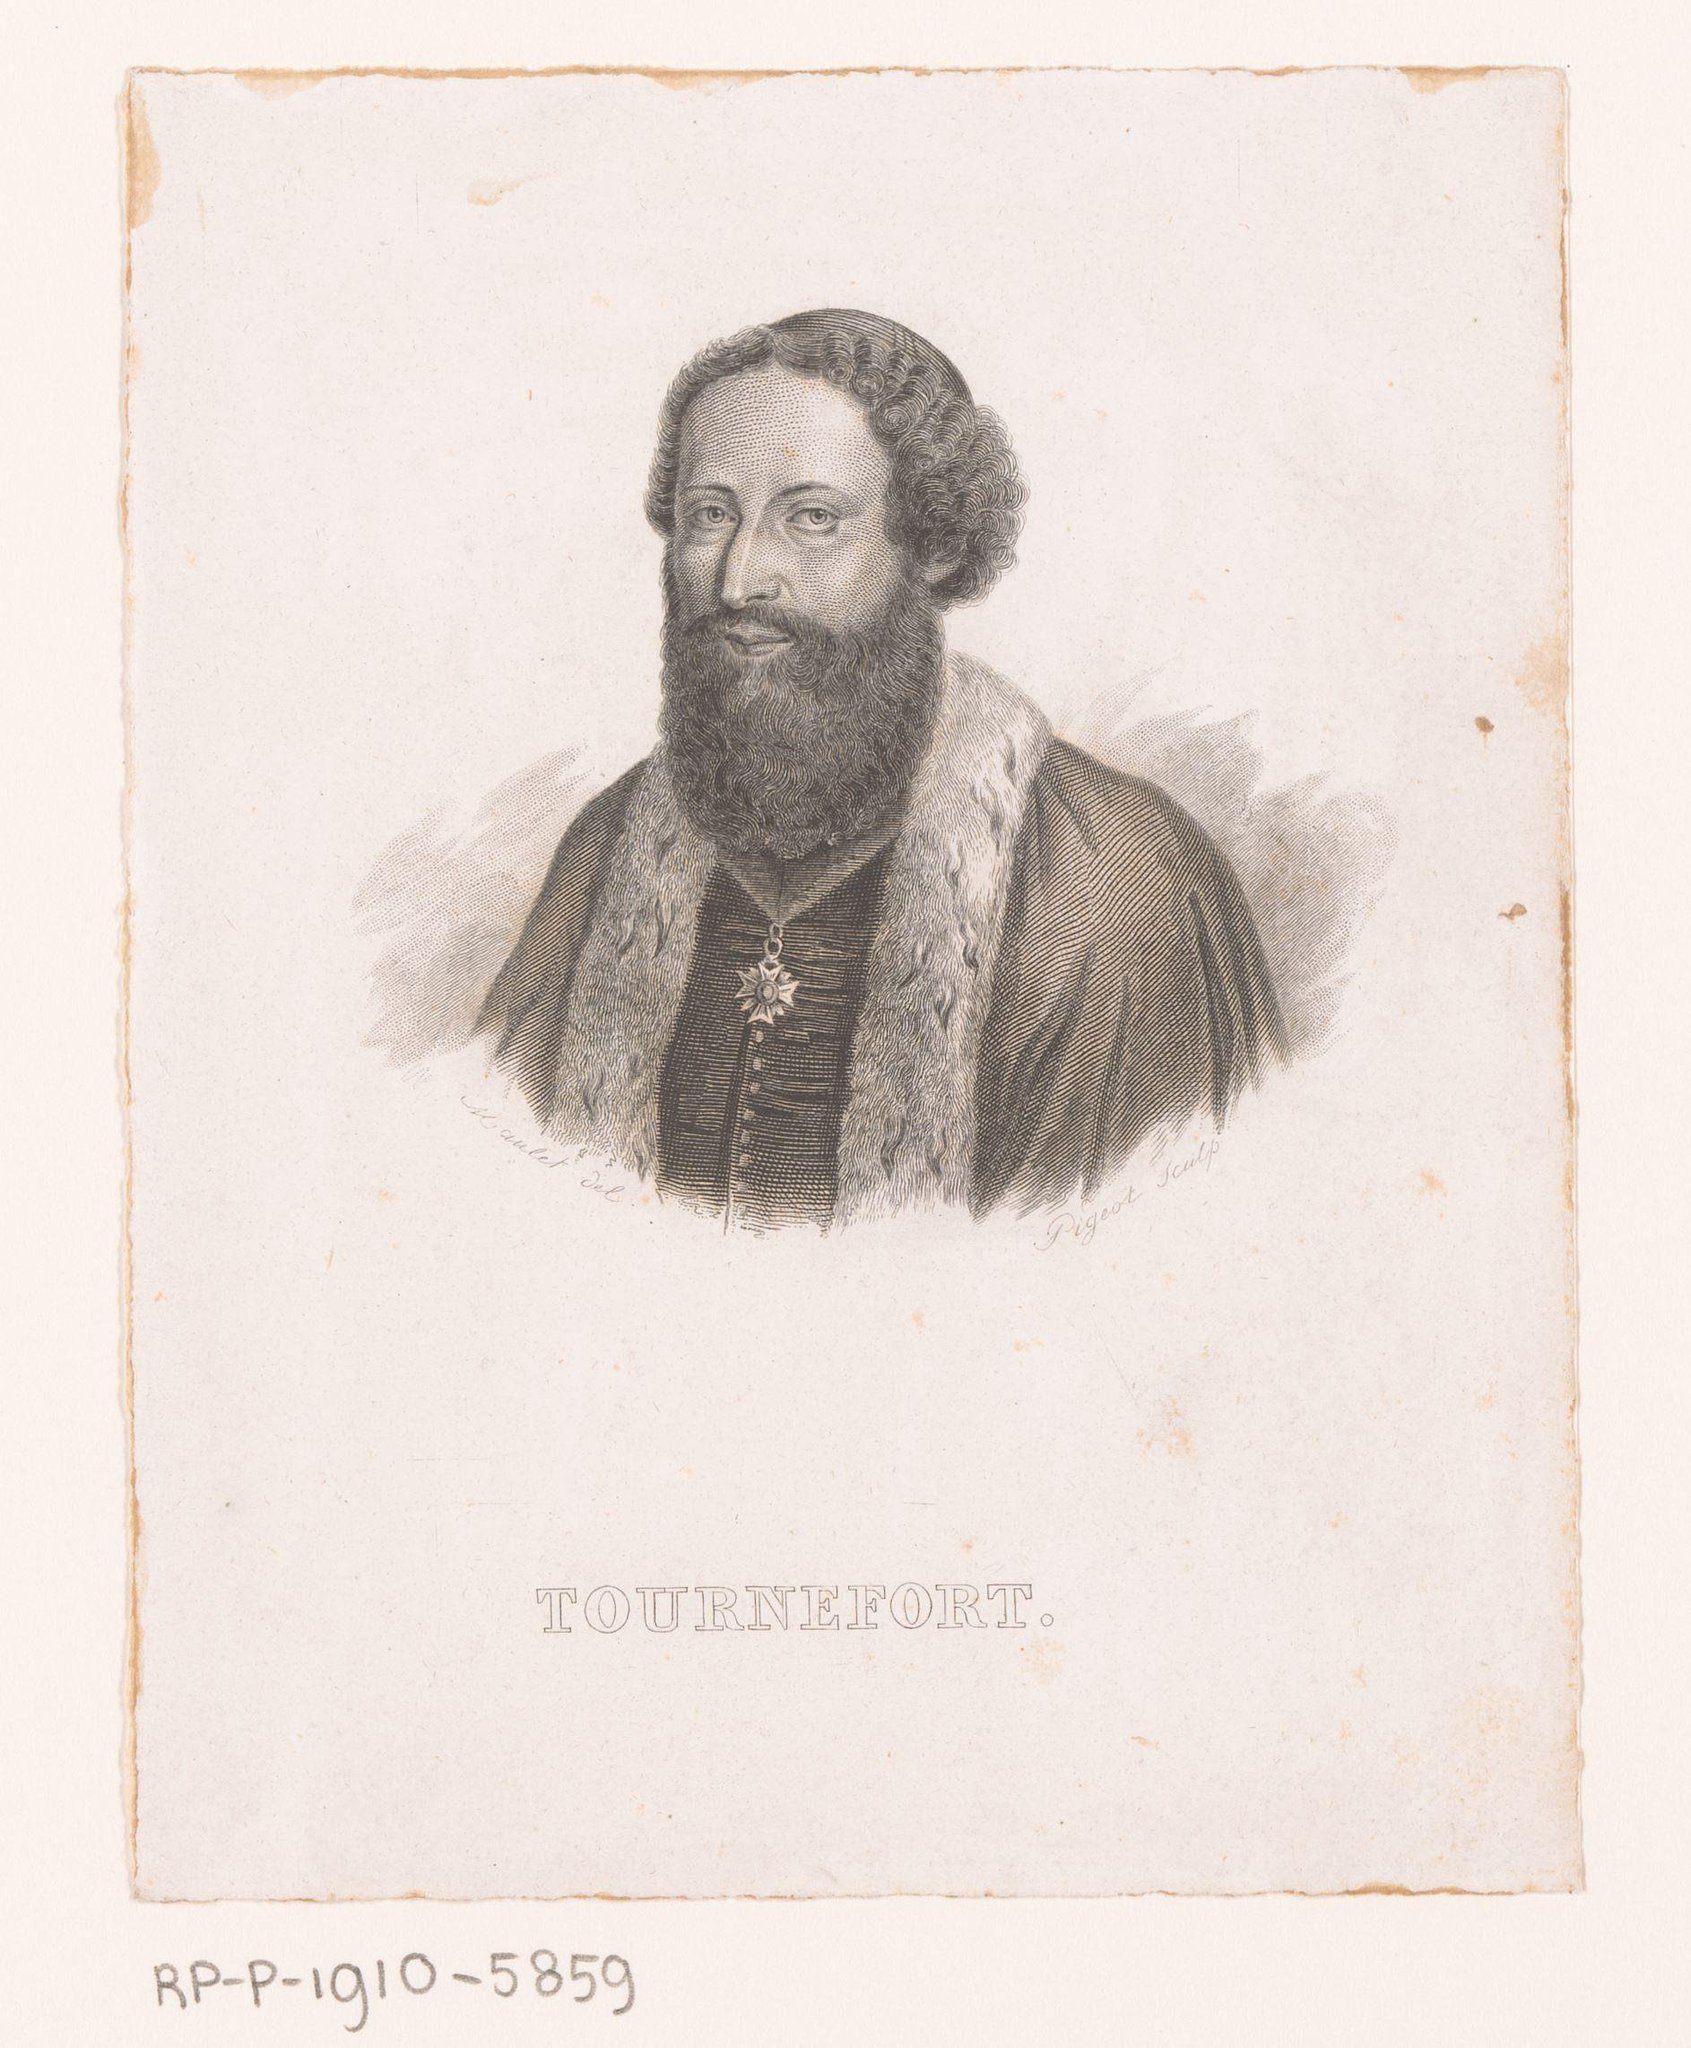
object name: print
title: Portret van Joseph Pitton de Tournefort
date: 1858-1874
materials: paper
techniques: engraving, etching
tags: paris, scholar, philosopher, historical persons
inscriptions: collector's mark: Lugt 2228